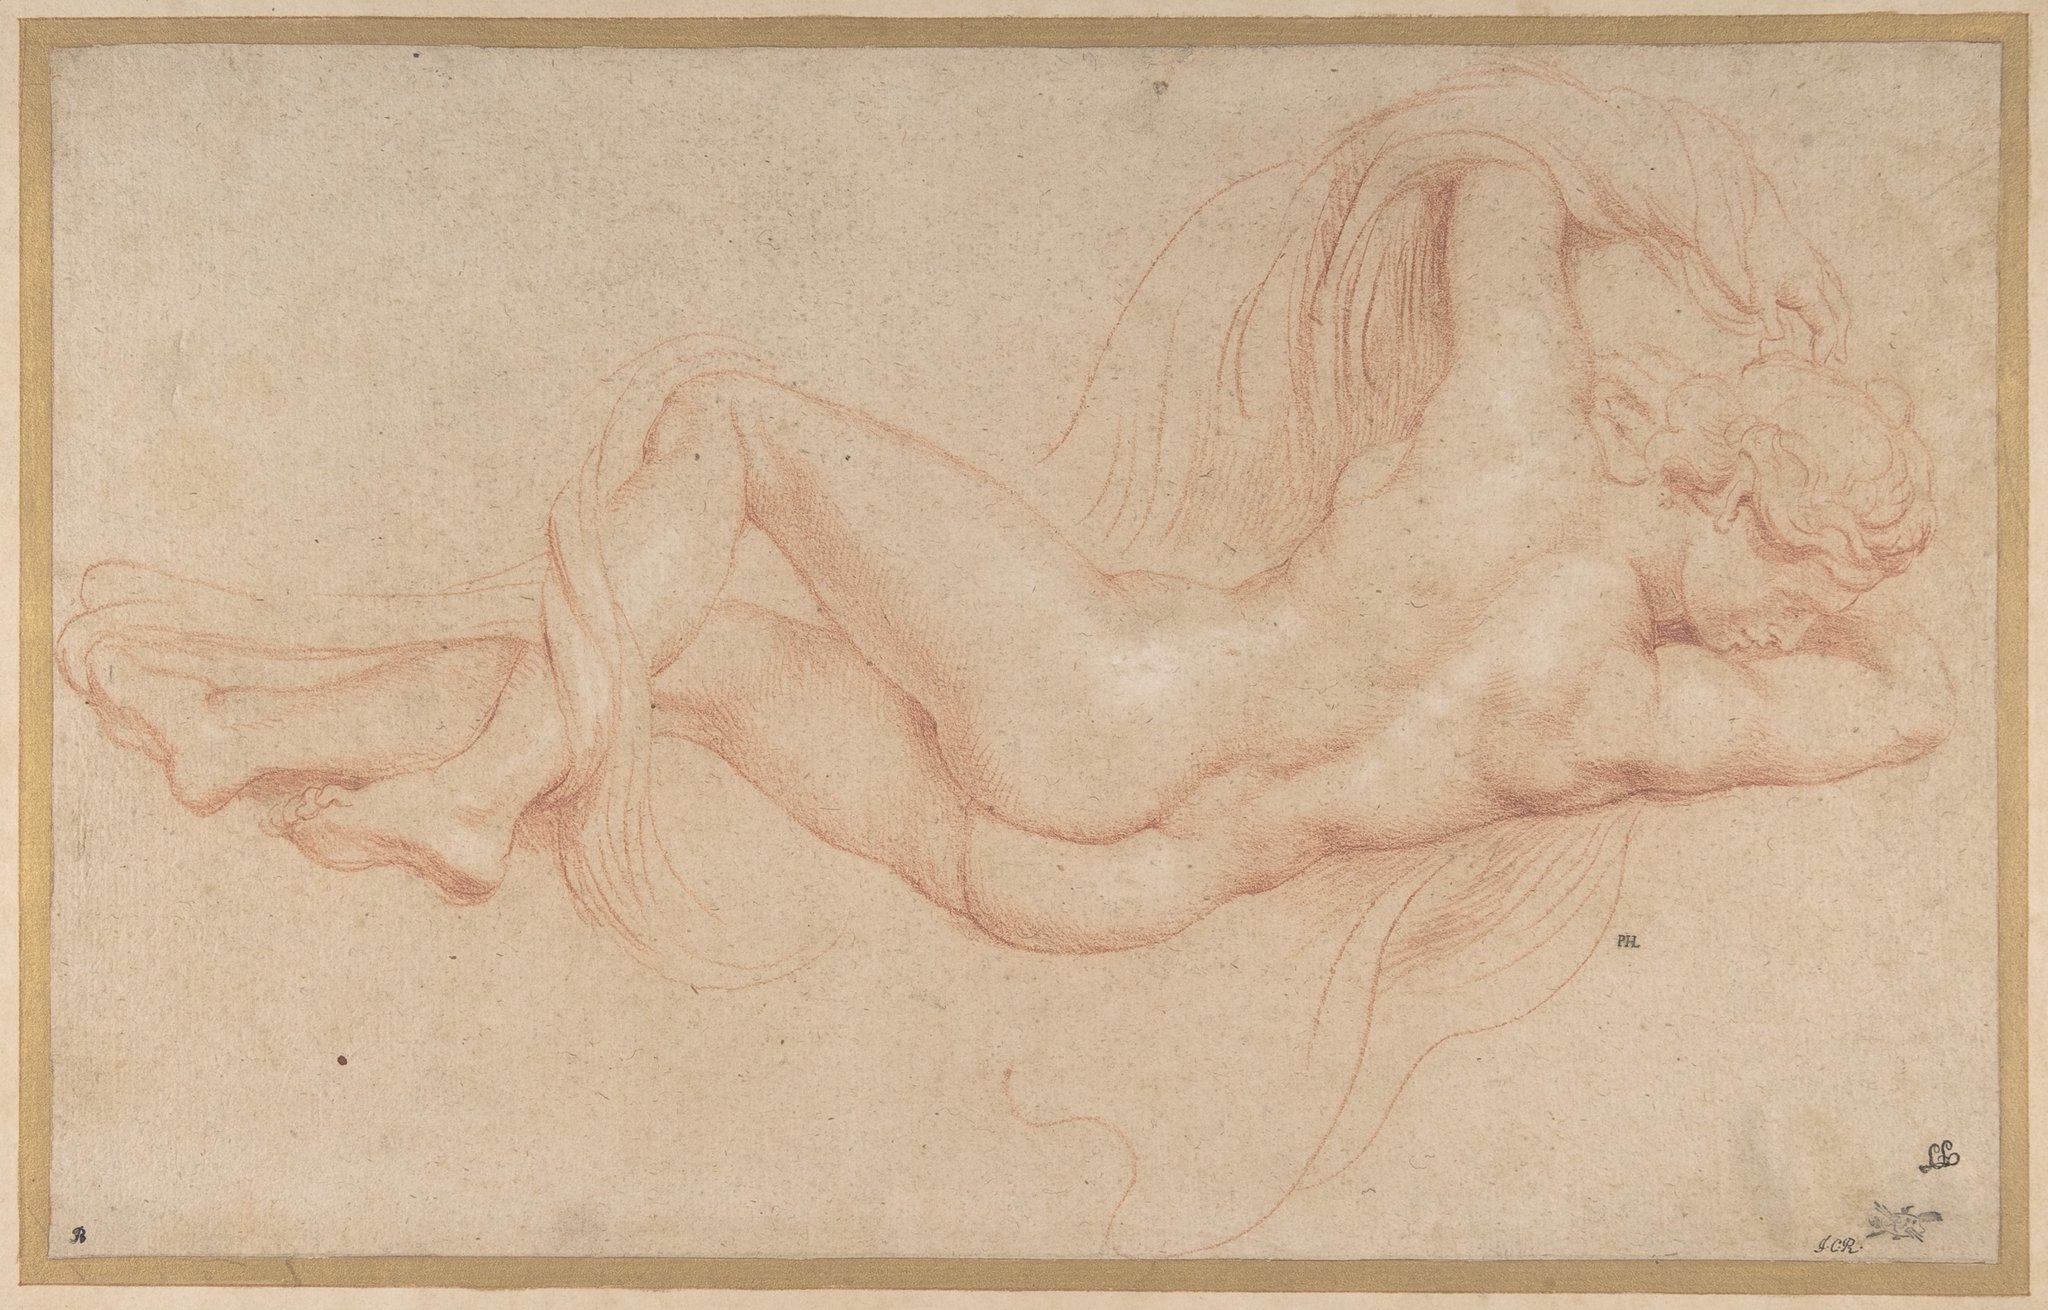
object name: drawing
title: Hermaphrodite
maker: peter paul rubens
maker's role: artist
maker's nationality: flemish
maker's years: 1577-1640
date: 1601-1700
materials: chalk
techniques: heightening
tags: hermaphrodites